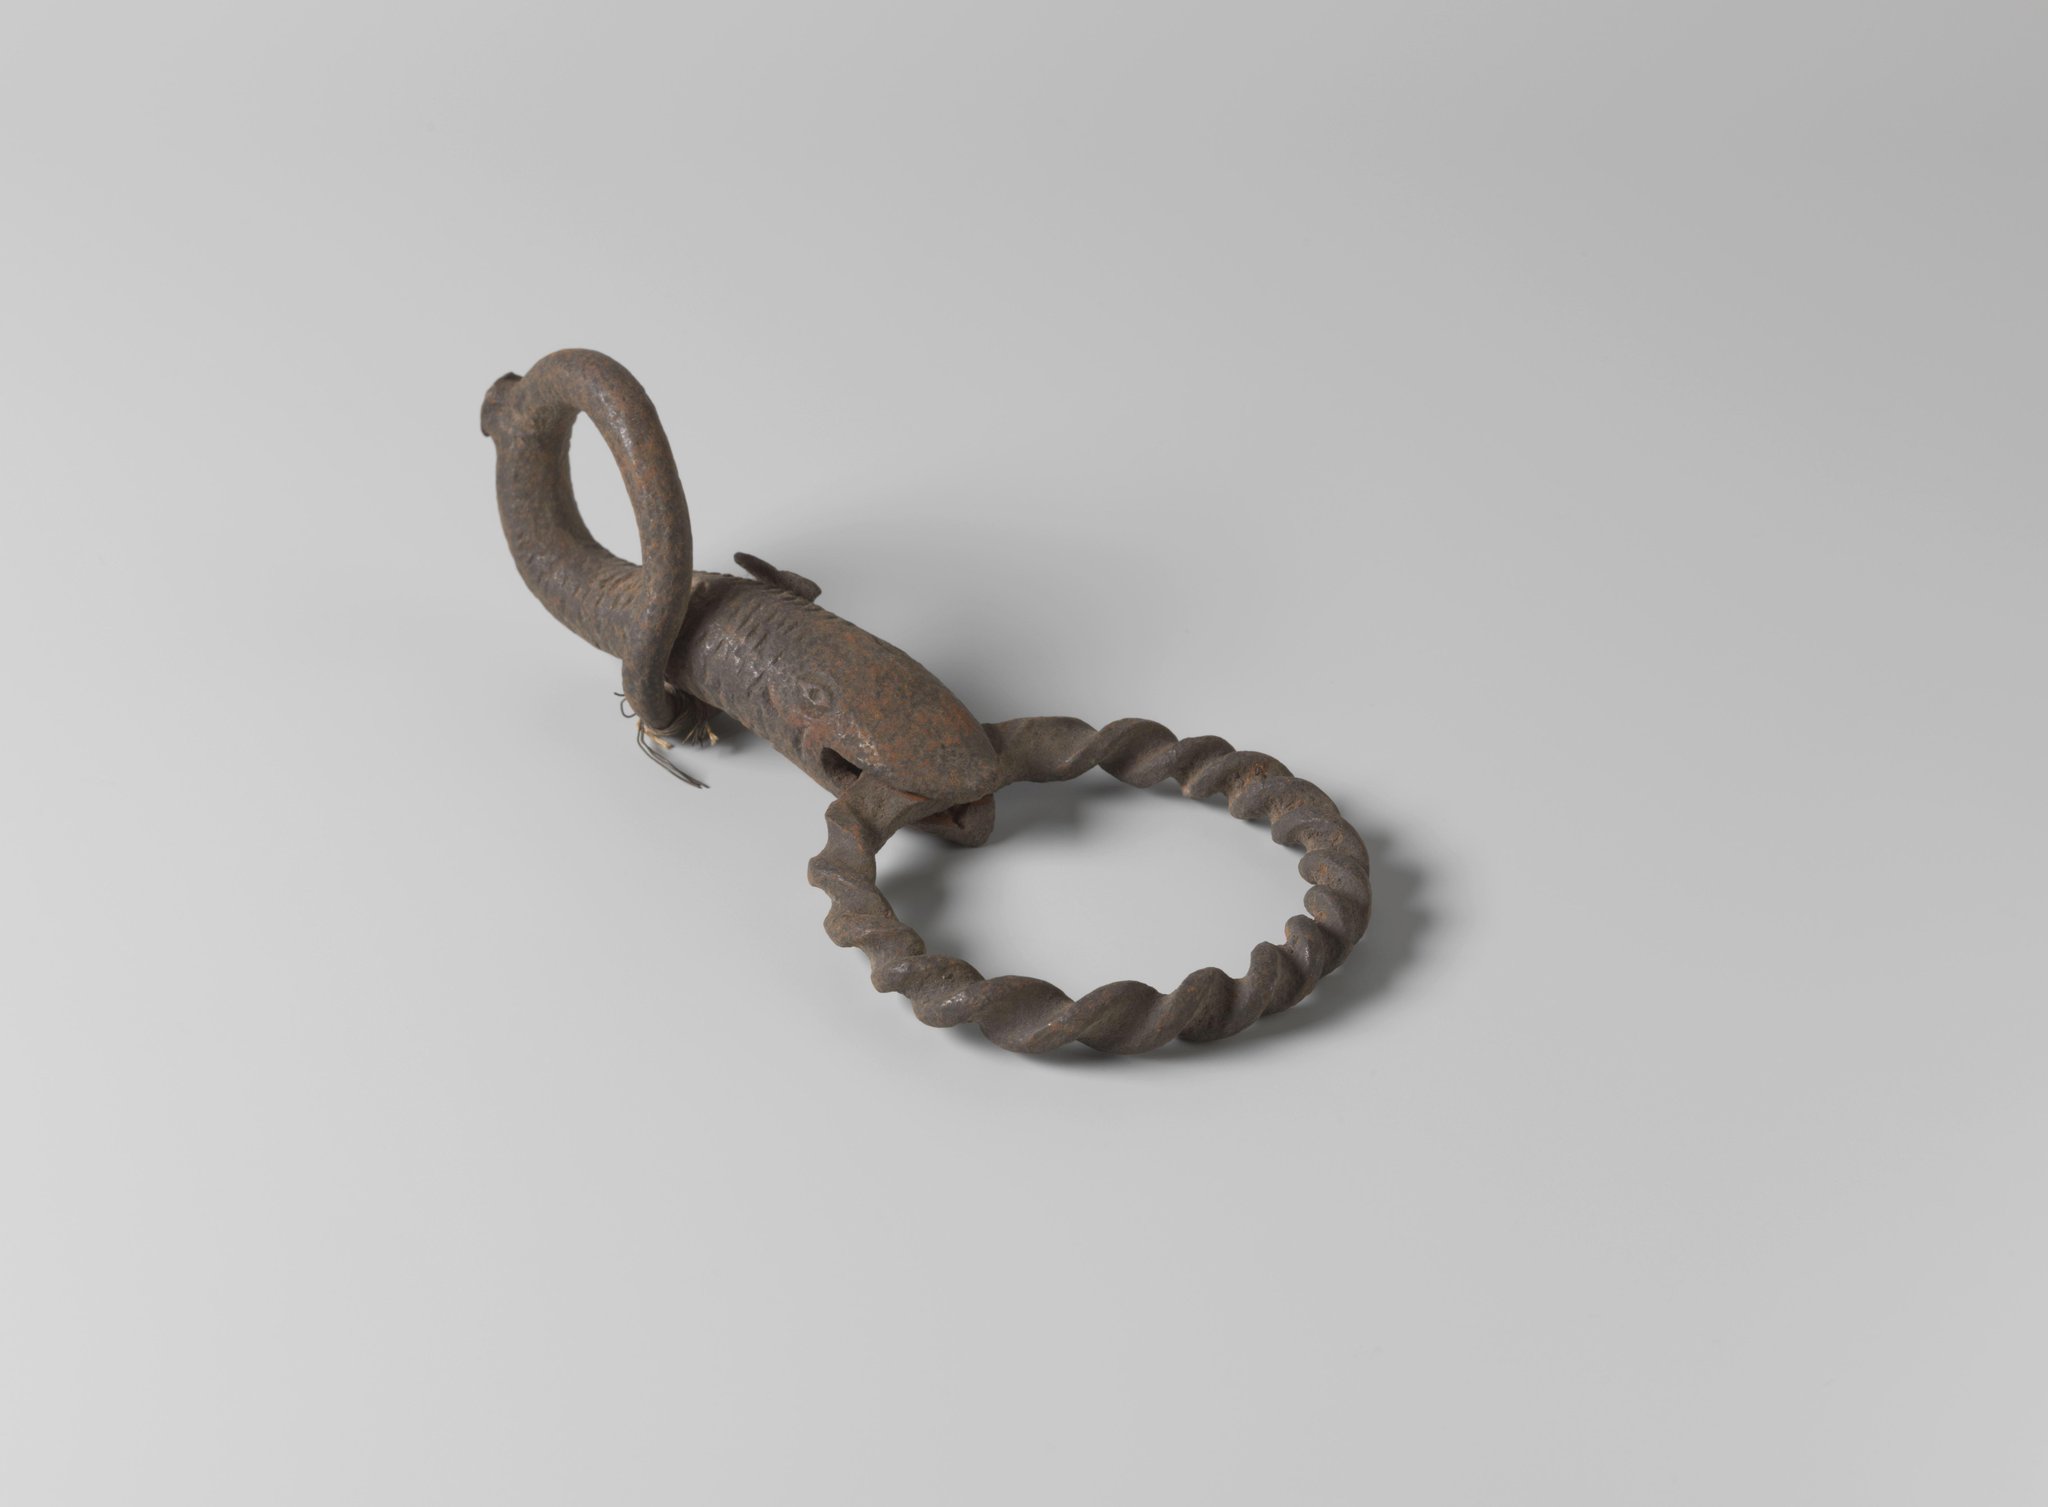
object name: ring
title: Getordeerde ring, vastgehouden door een vis, vermoedelijk onderdeel van een bellentrekker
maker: Anonymous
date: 1600-1699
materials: iron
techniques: forging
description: Gesmeed ijzeren getordeerde ring vastgehouden door een vis met gekrulde staart, vermoedelijk een bellentrekker.